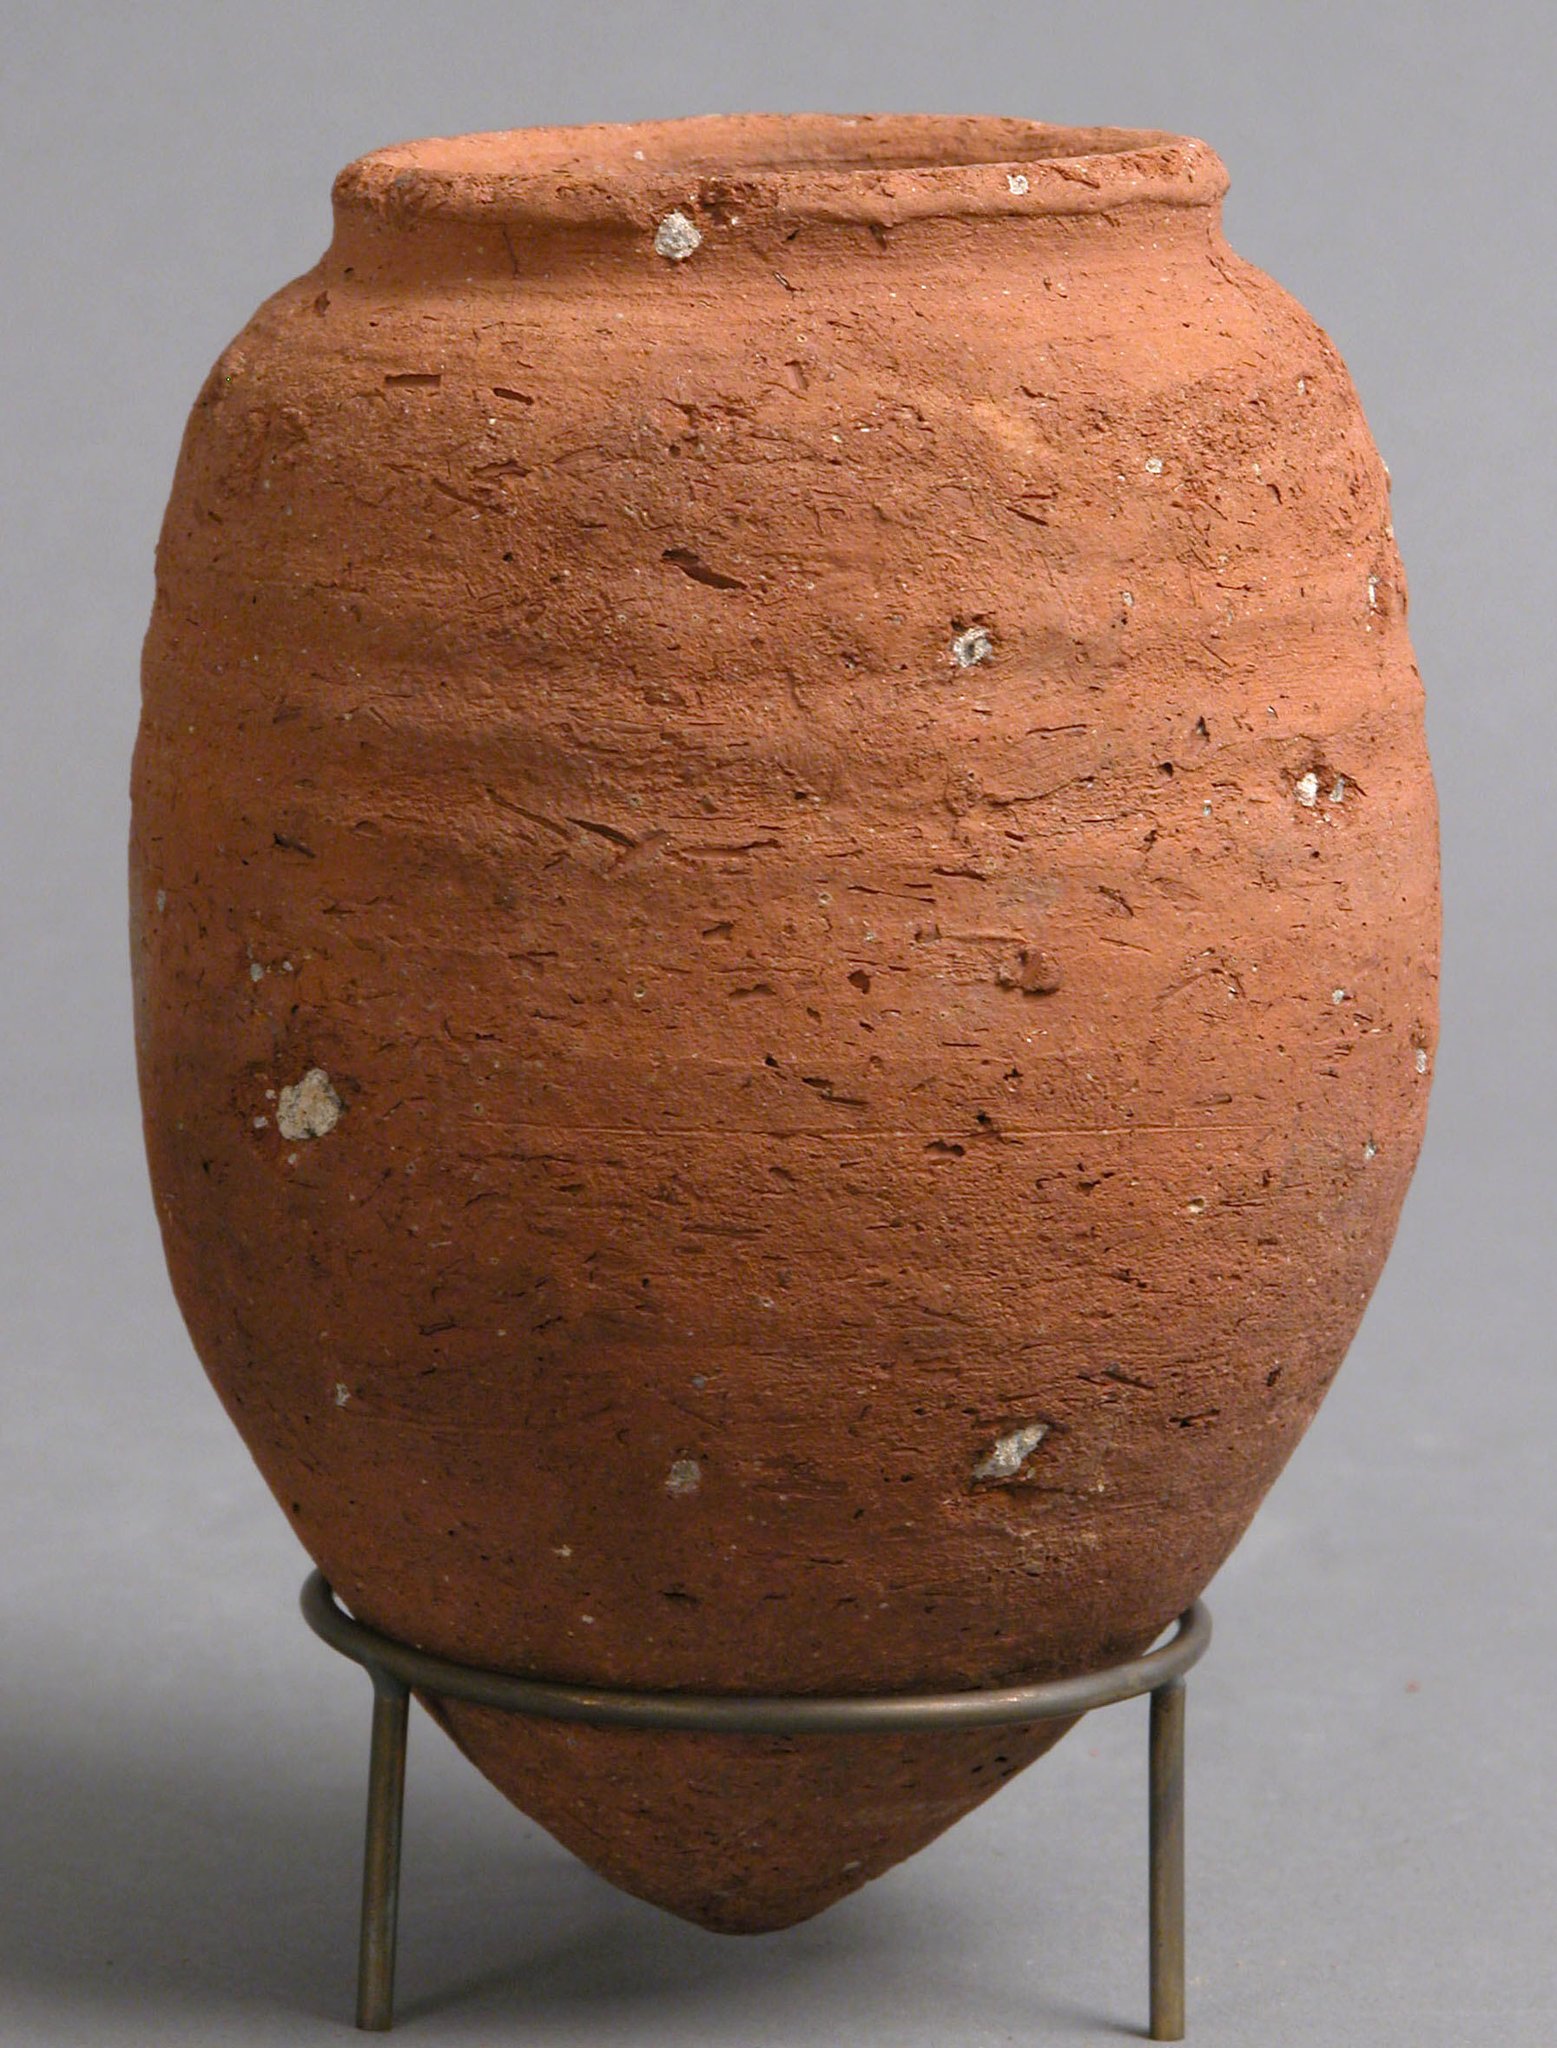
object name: jar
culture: coptic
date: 301-700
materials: earthenware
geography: egypt